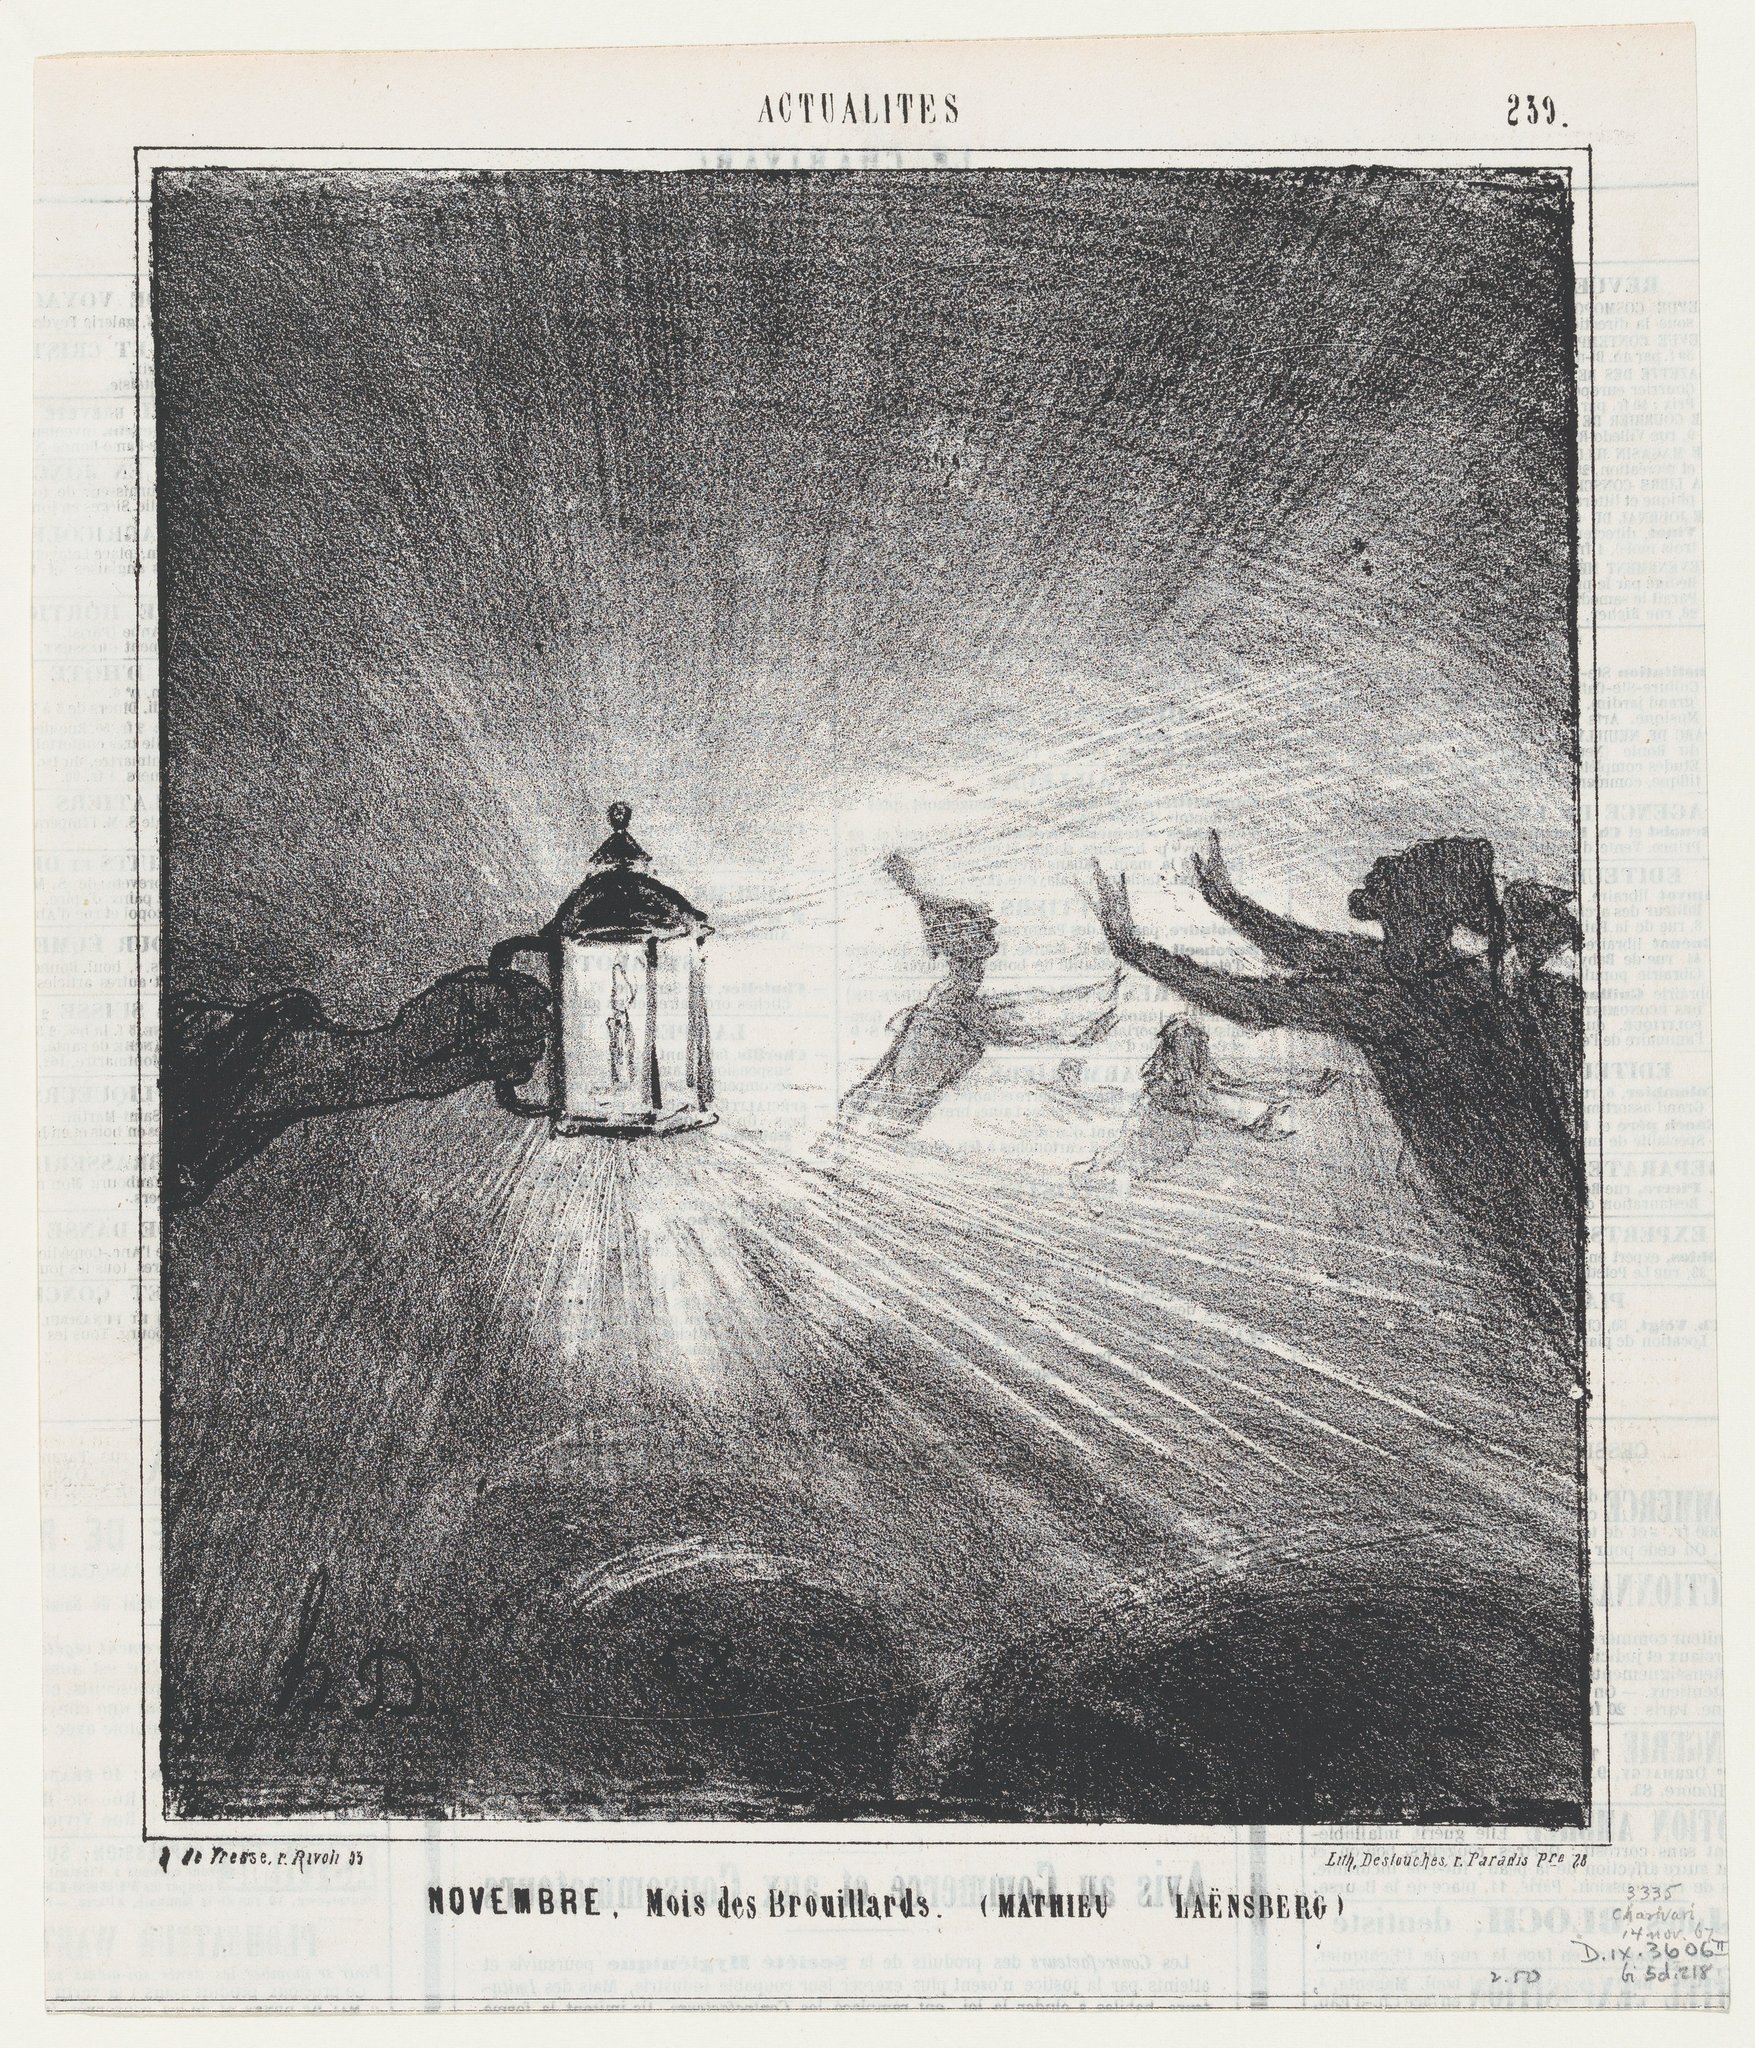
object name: print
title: November, month of fog (Matthieu de Laensberg), from 'News of the day,' published in Le Charivari, November 14, 1867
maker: honoré daumier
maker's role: artist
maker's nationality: french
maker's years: 1808-1879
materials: paper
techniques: lithograph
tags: satire,fog,lamps